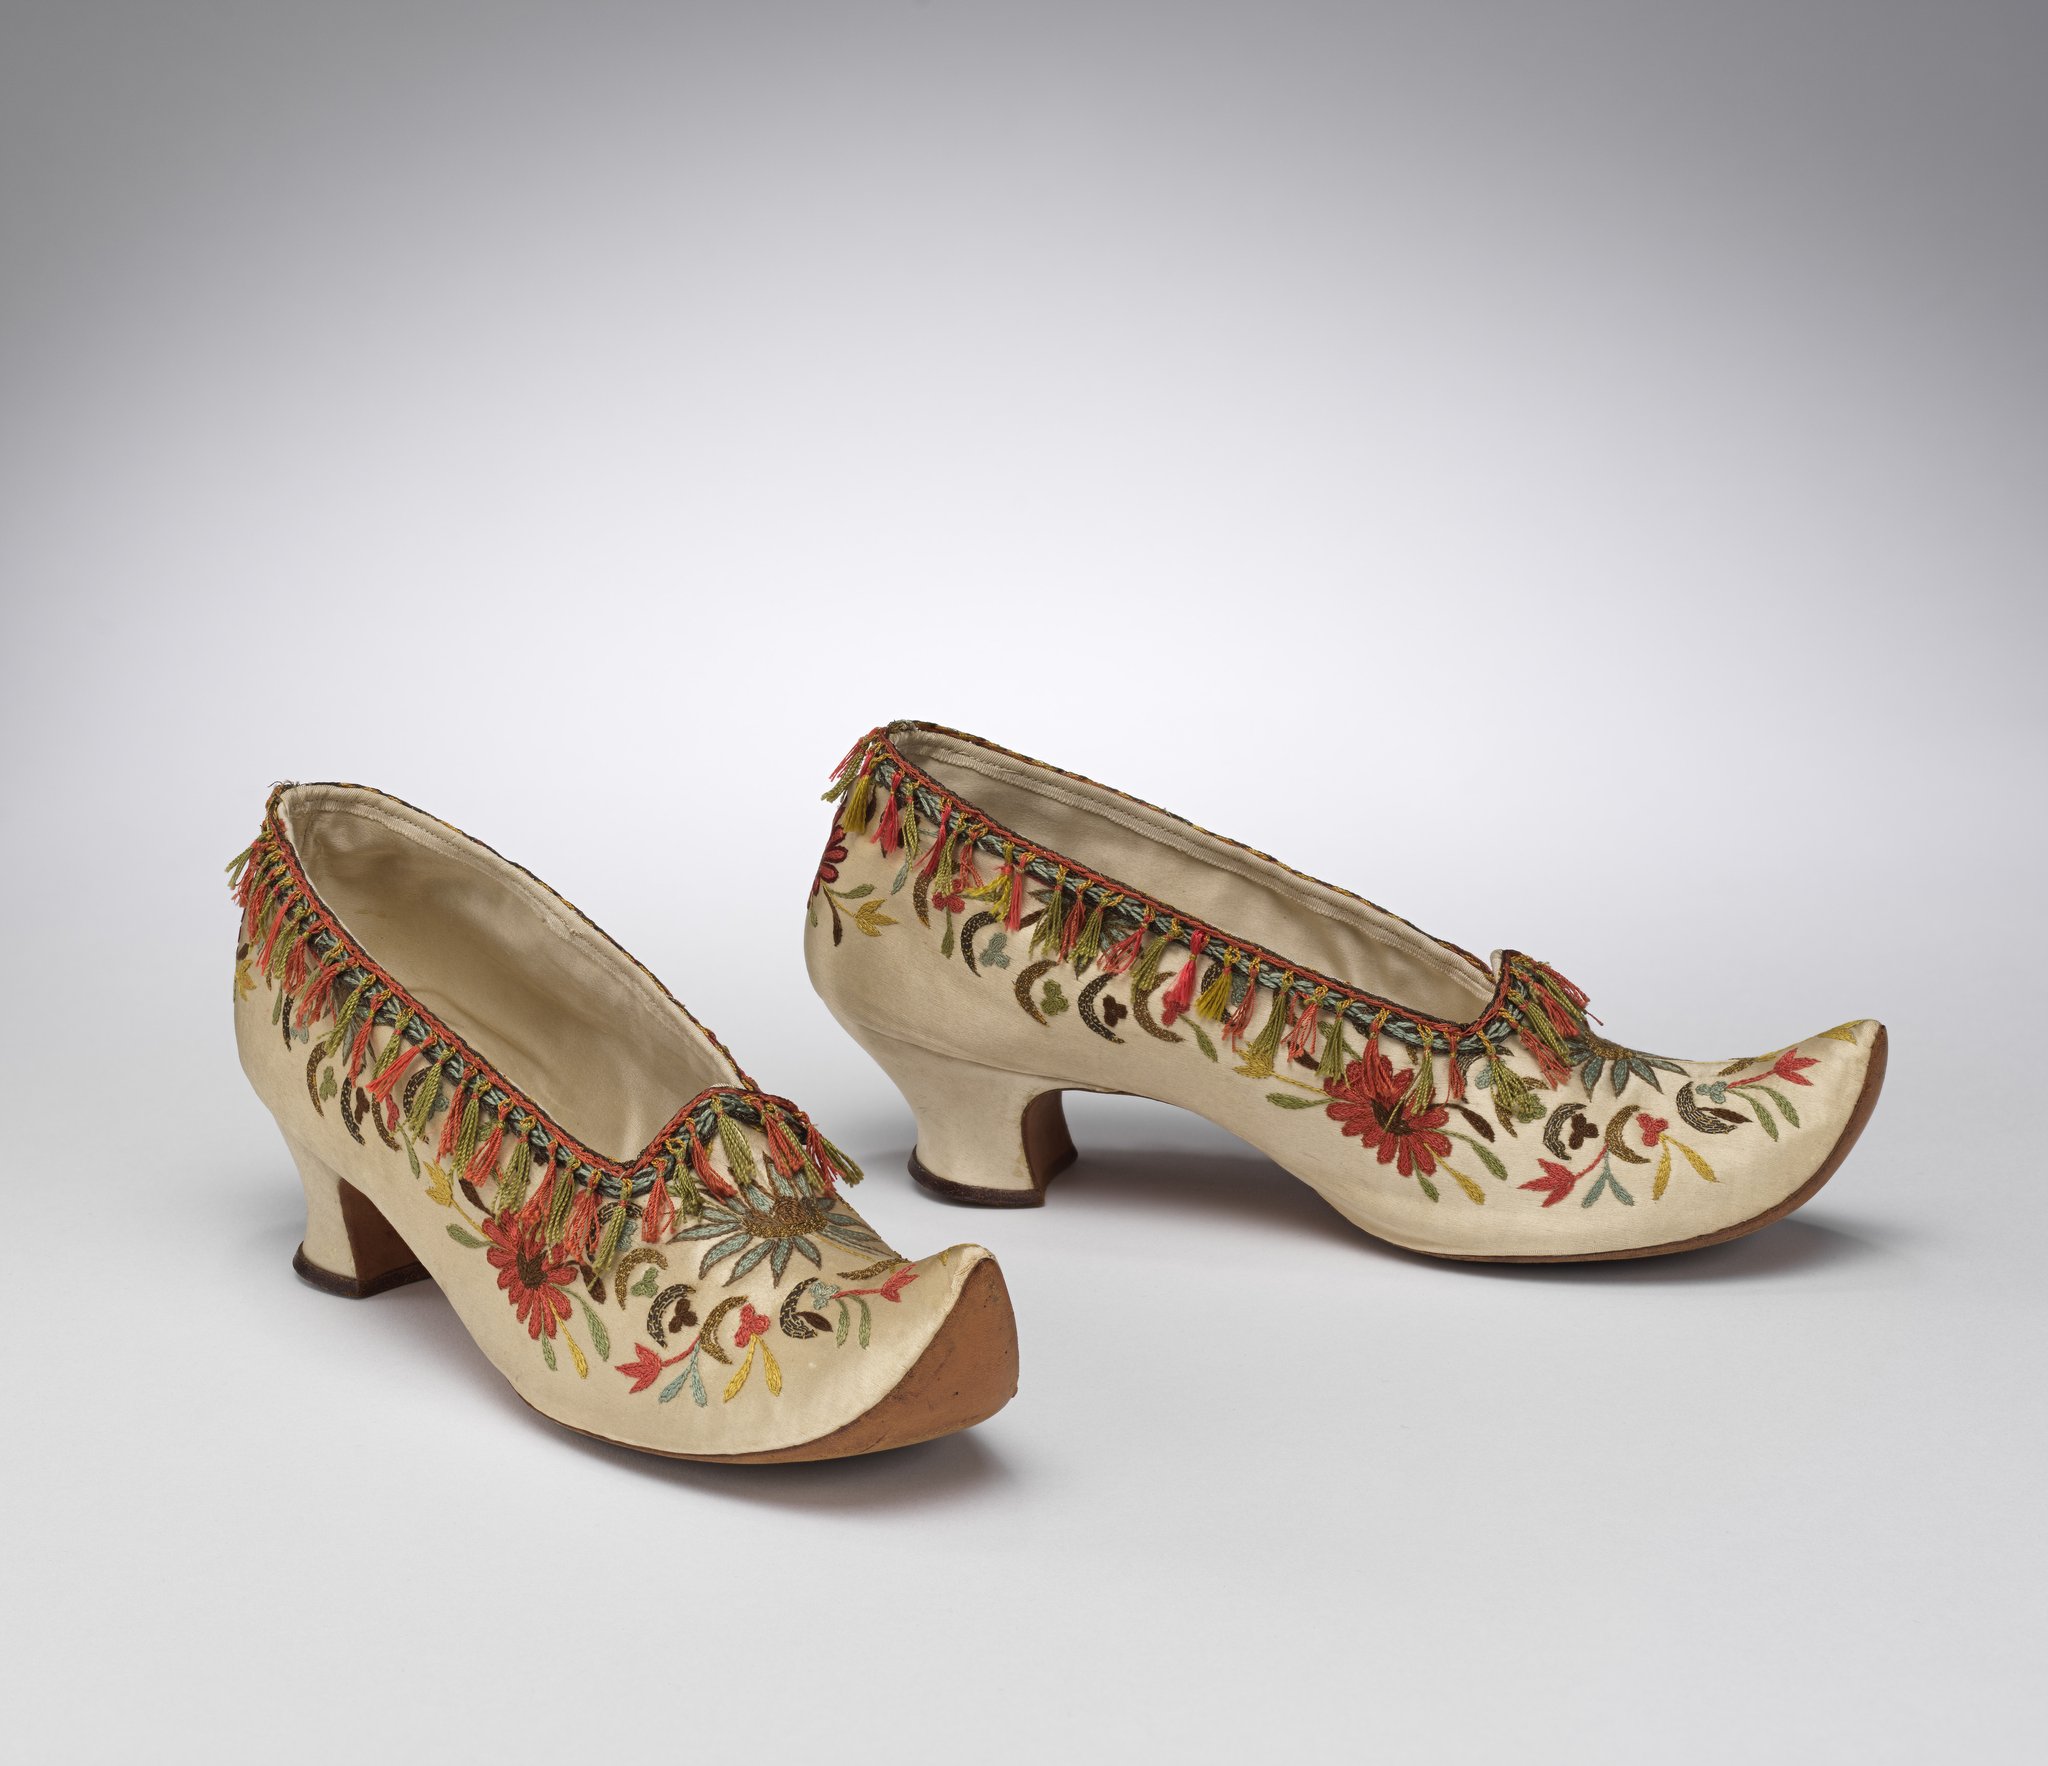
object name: shoe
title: Shoes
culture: french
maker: hellstern and sons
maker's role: designer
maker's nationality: french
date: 1870-1879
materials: silk